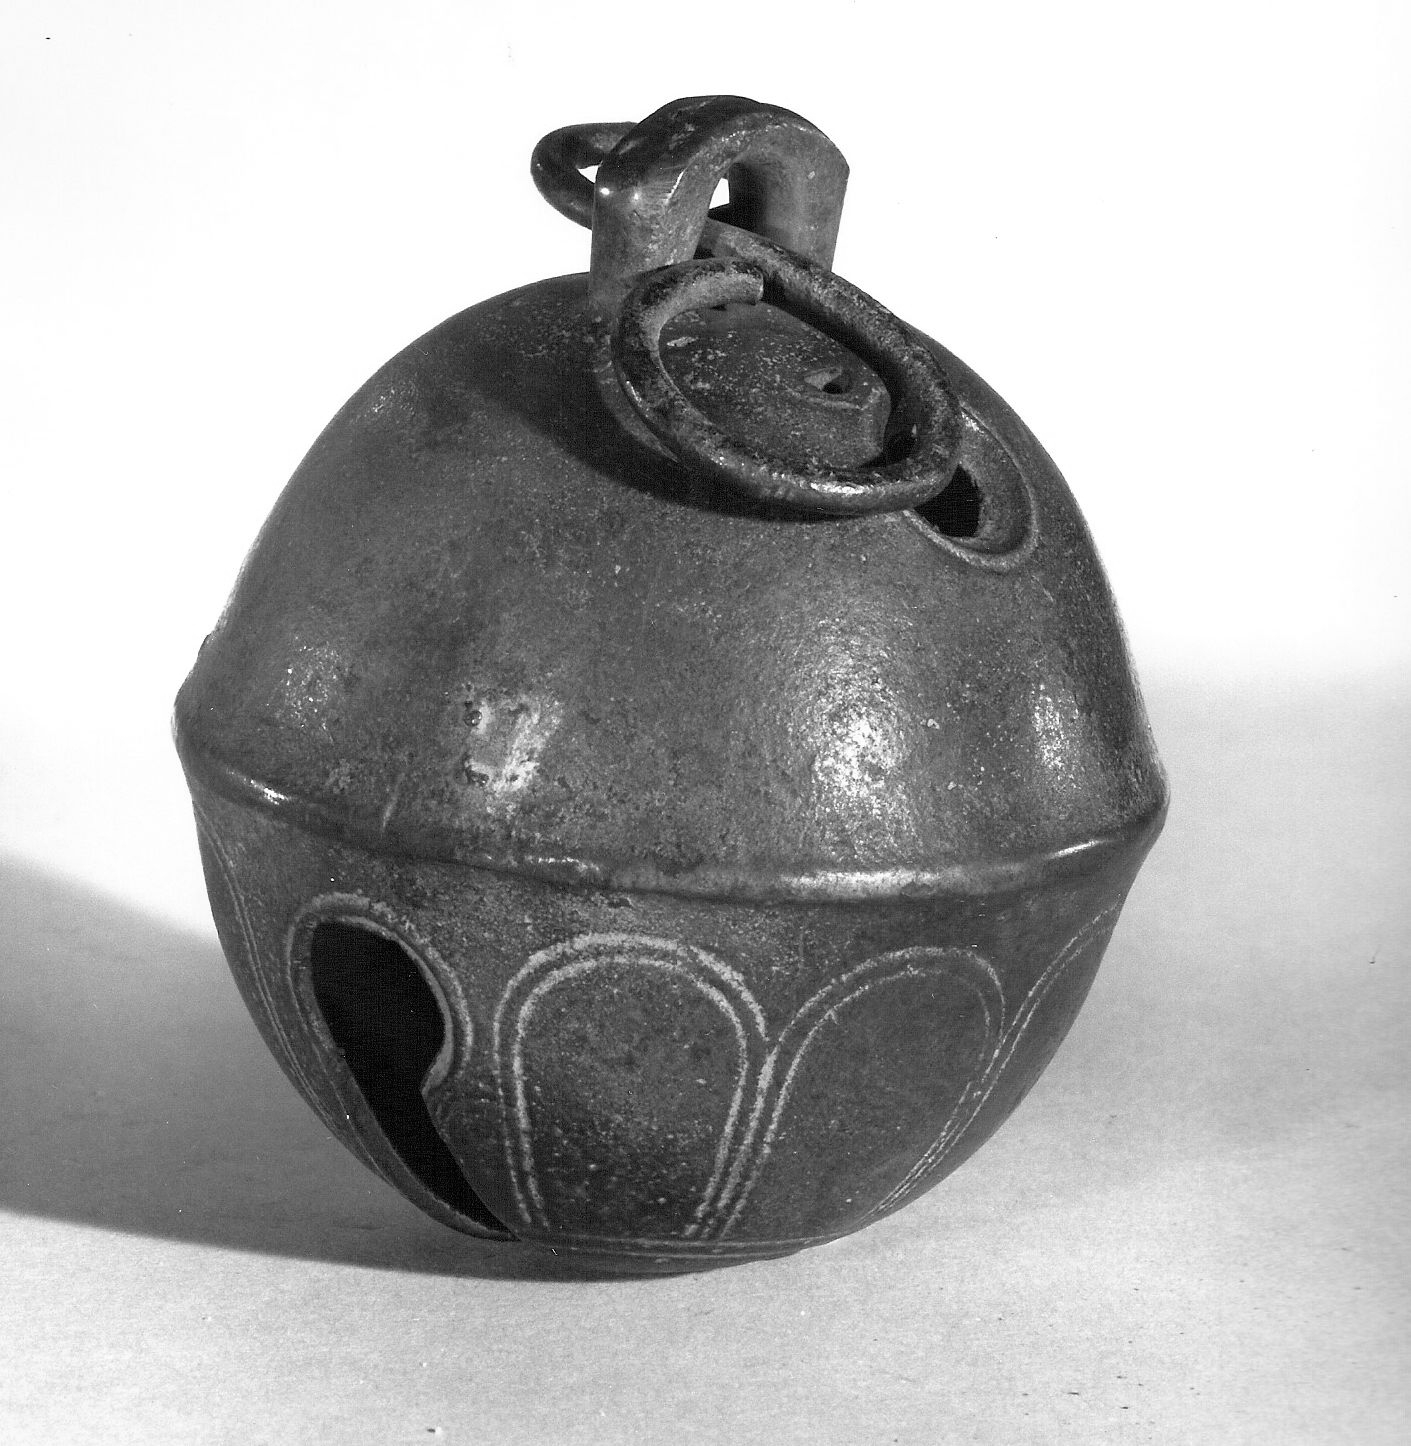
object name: pellet bell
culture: american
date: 1767-1800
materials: bronze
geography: united states